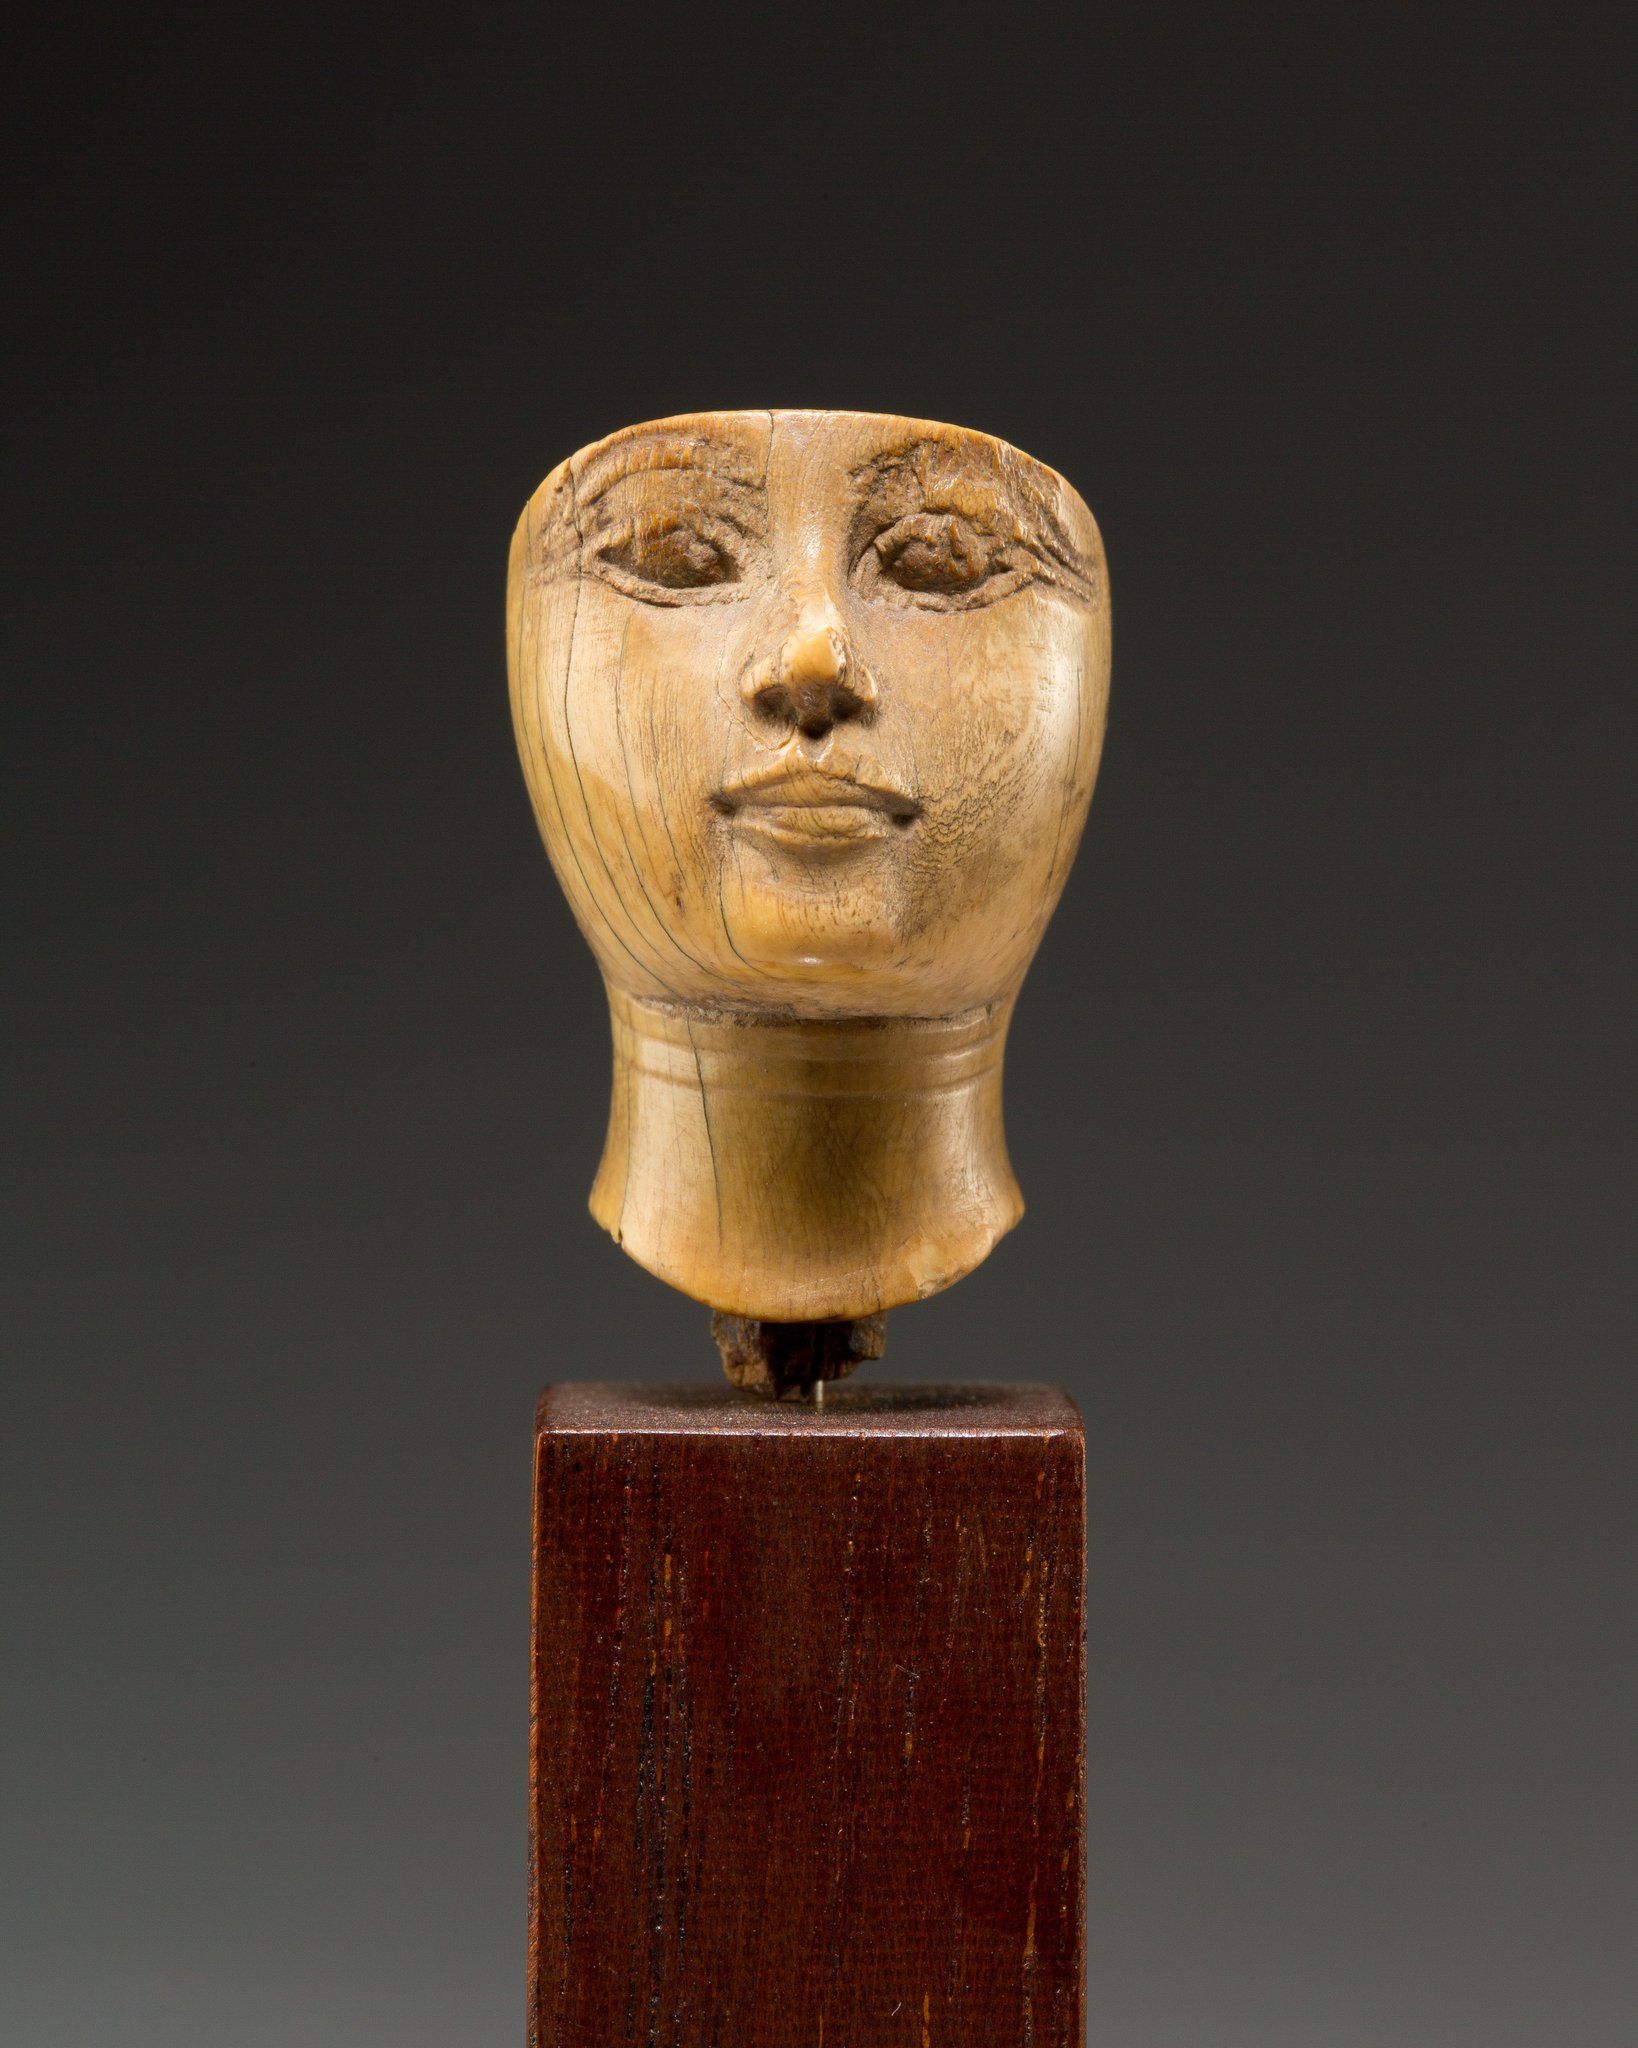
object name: head, female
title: Head of a woman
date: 1390-1352 BCE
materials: ivory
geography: fayum entrance area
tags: heads,women